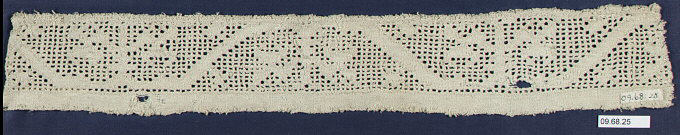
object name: border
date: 1501-1700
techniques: embroidery